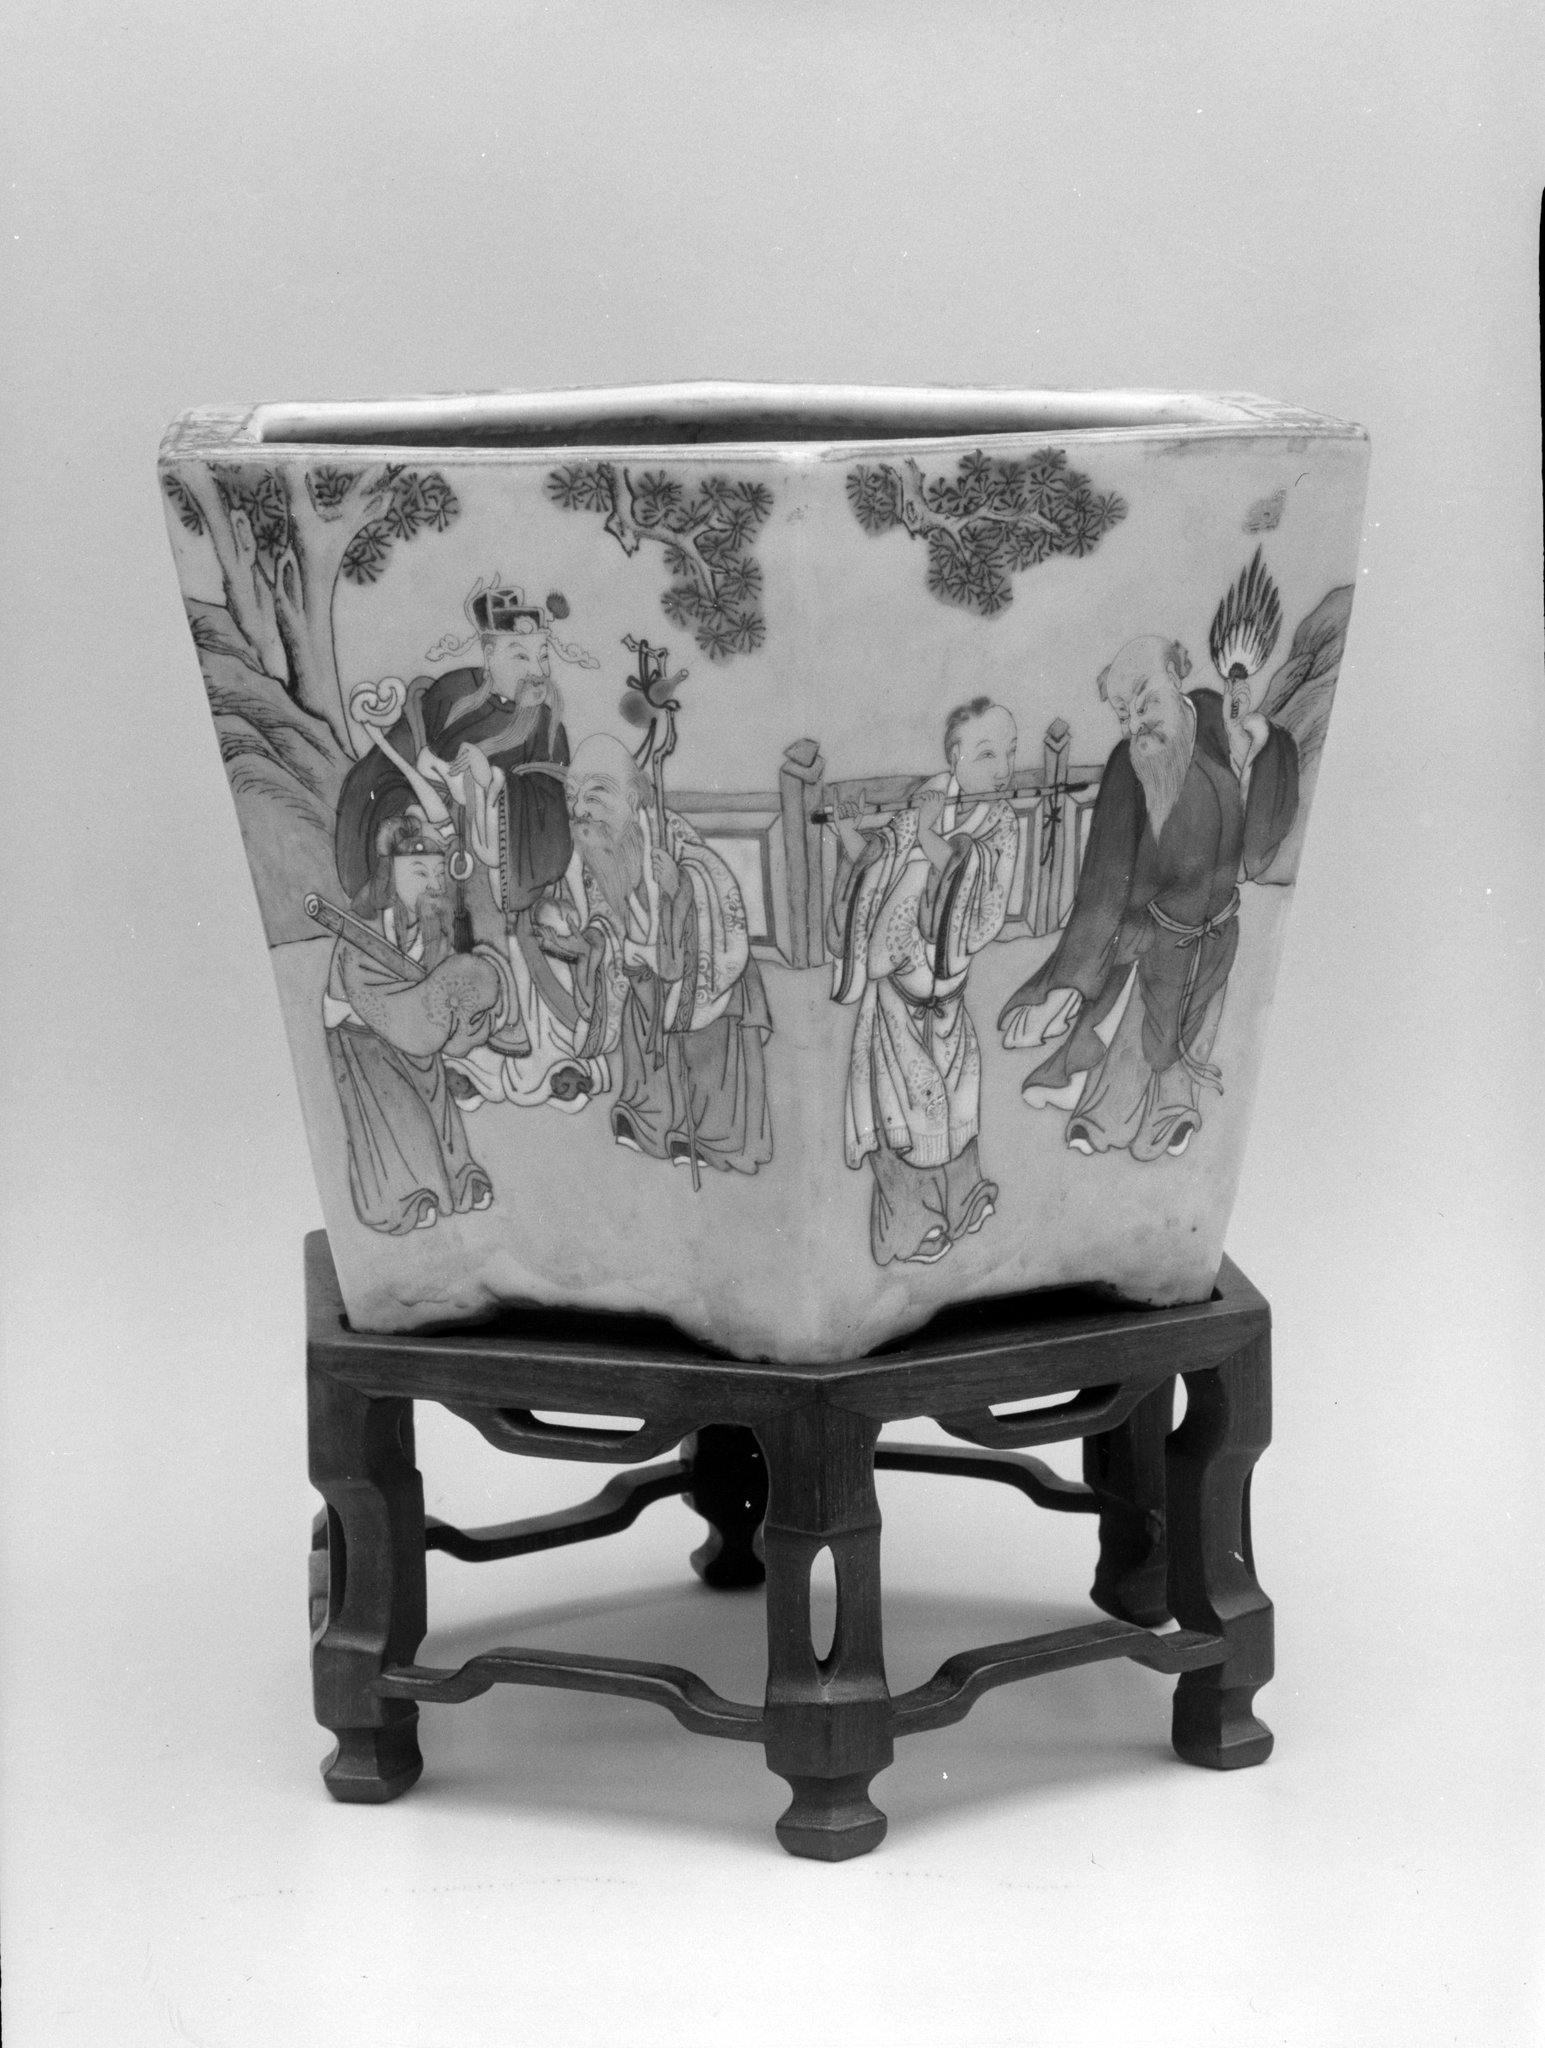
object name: jardinière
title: Jardiniere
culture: chinese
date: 1700-1800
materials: porcelain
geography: china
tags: men